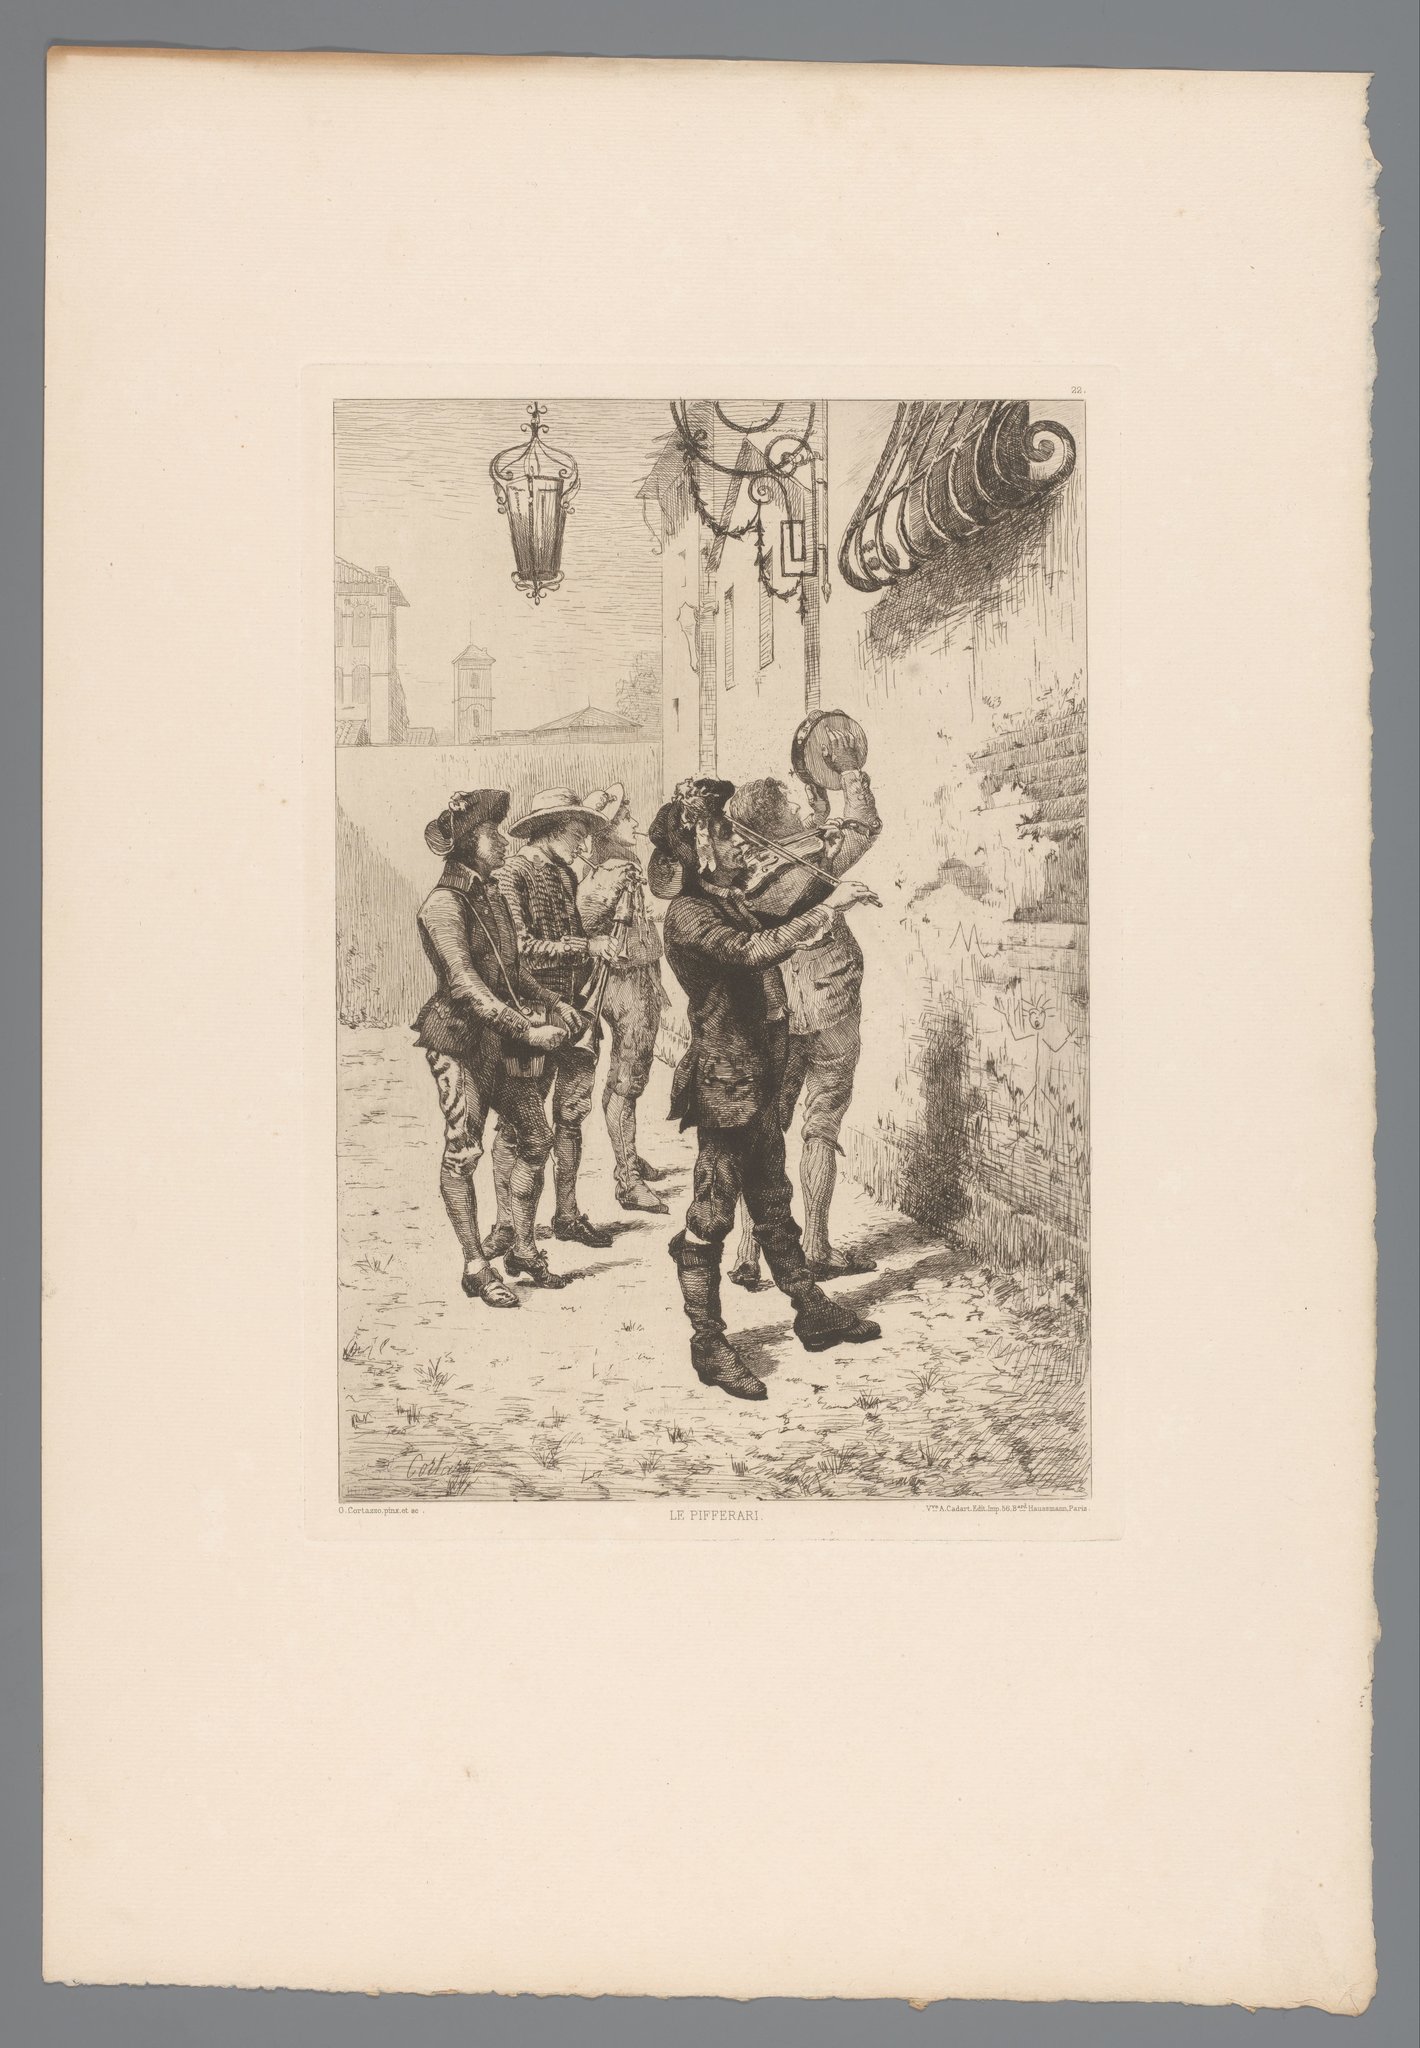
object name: print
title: Le pifferari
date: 1881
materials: paper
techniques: drypoint, etching, intaglio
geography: paris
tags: musician - cc - out of doors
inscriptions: watermark, collector's mark: Lugt 2760, collector's mark: ‘AFE v S’, collector's mark: Lugt 2228